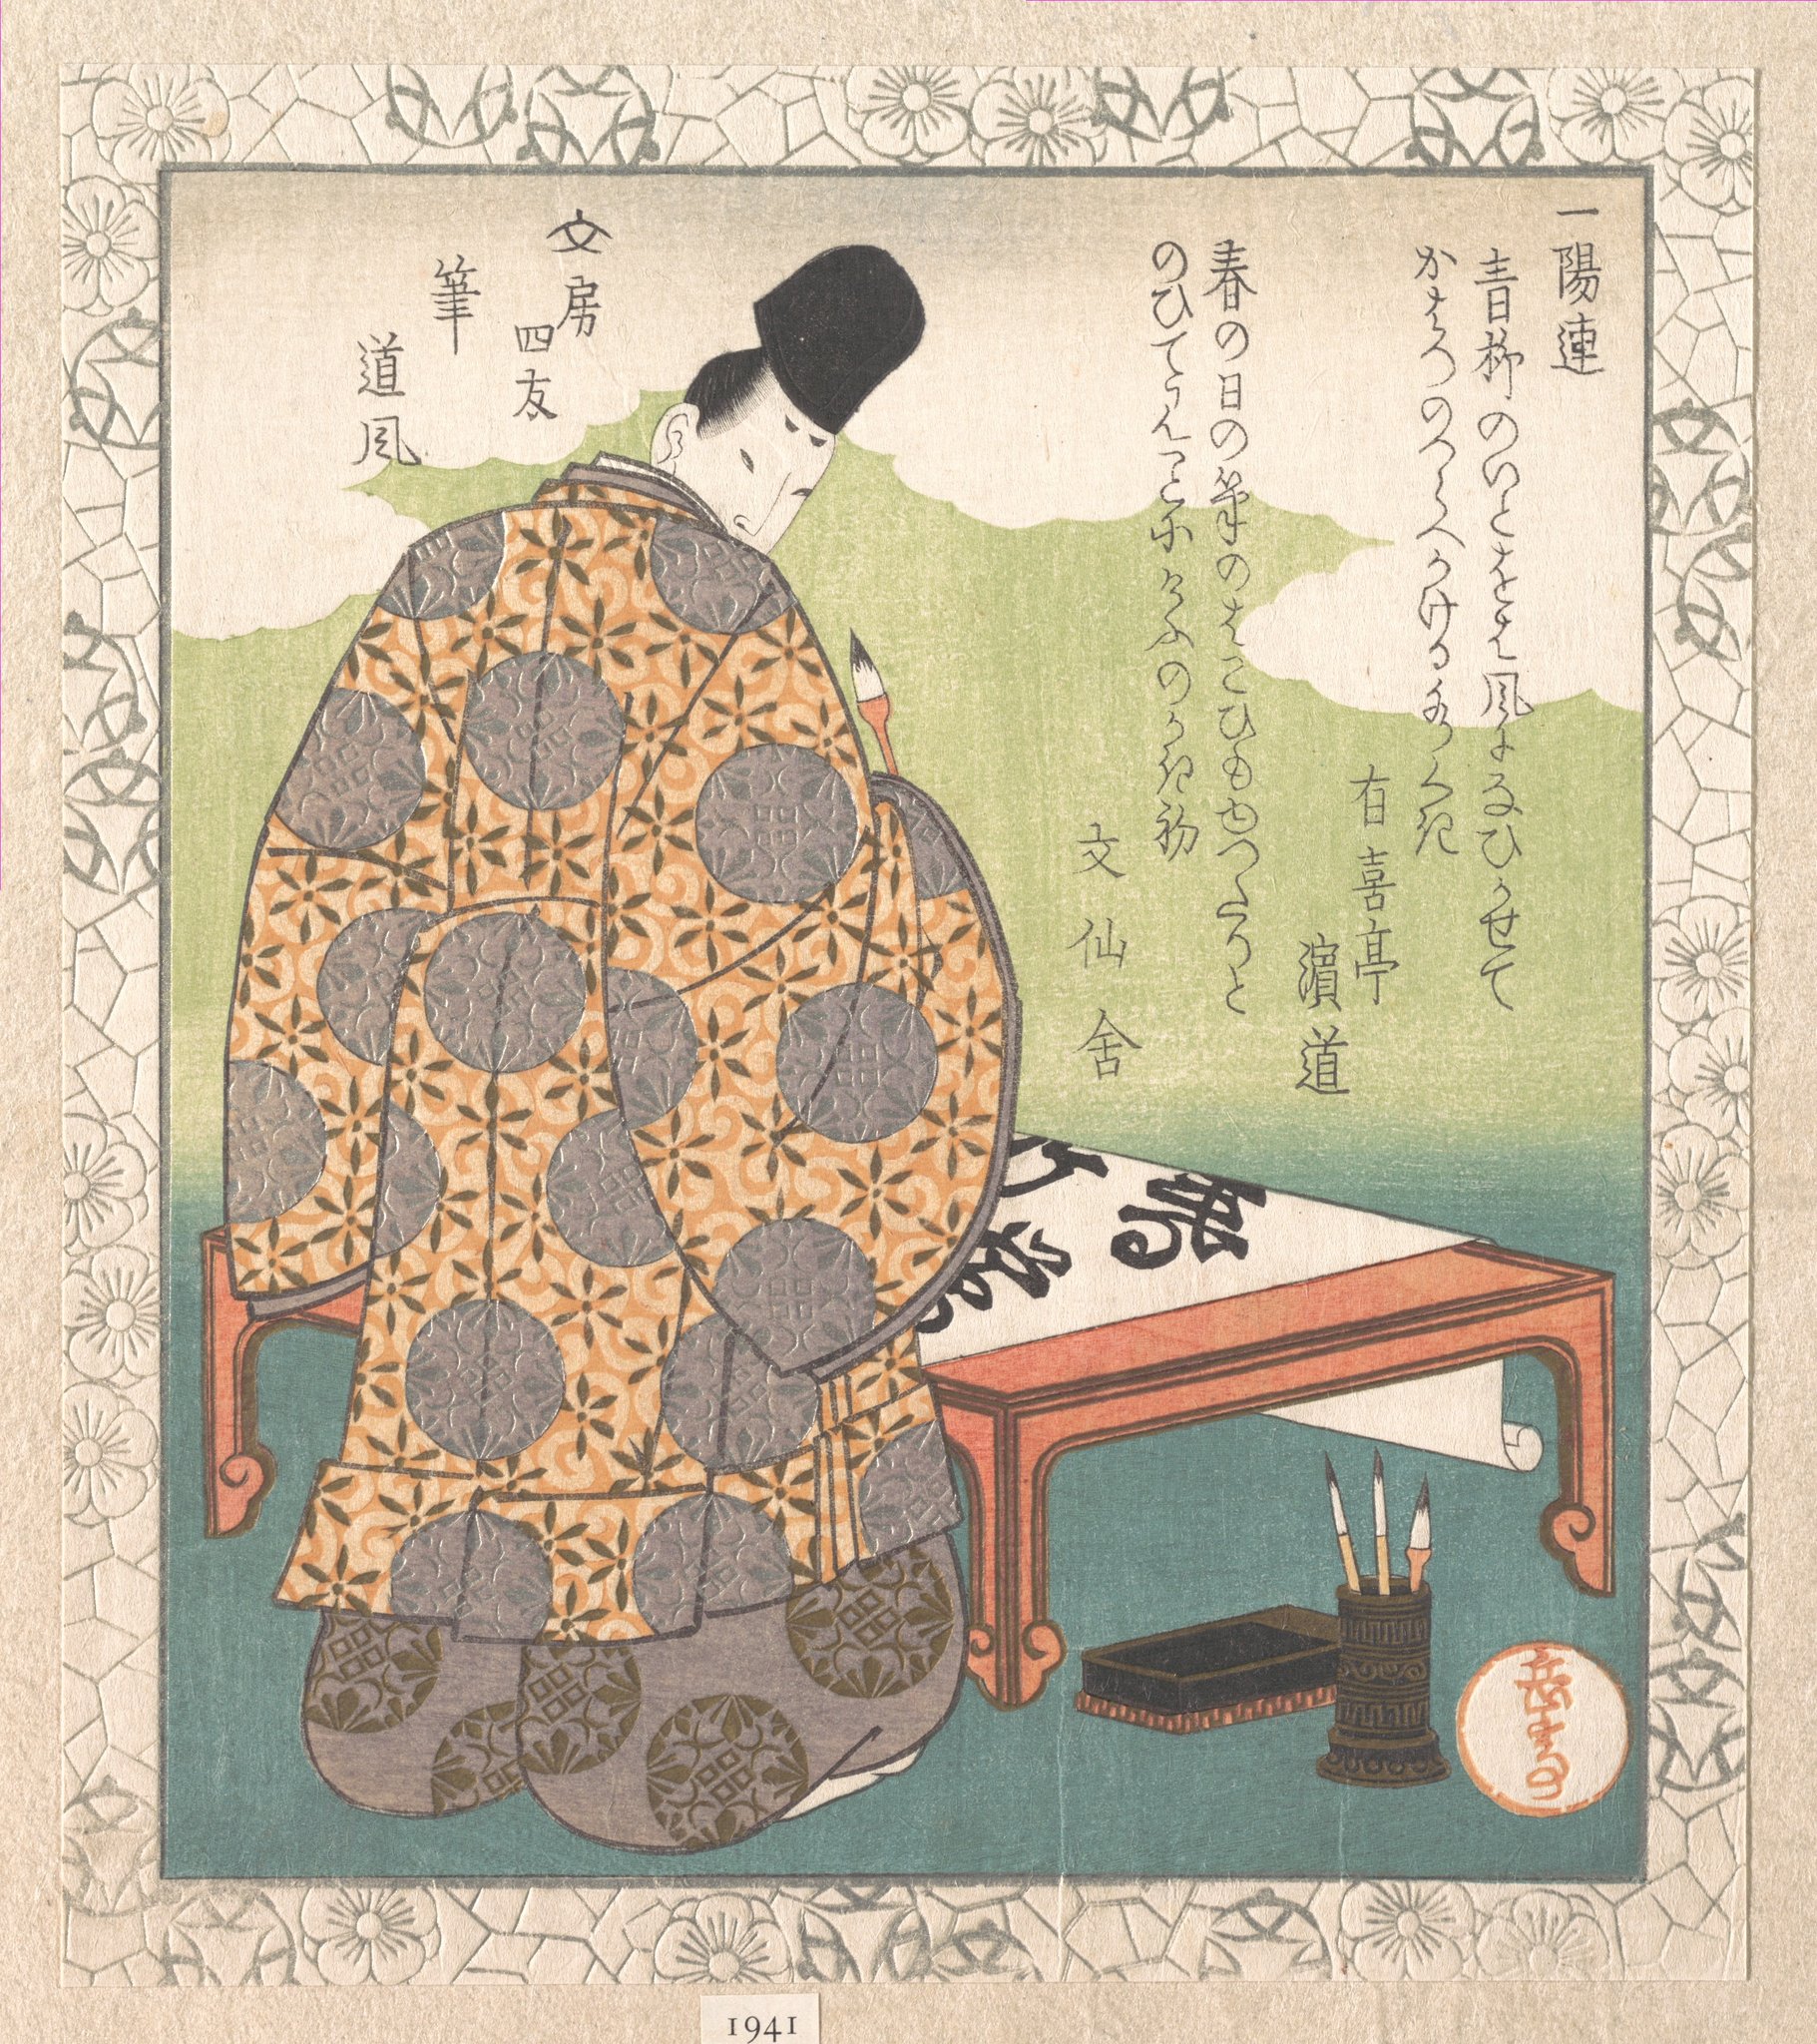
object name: print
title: The Heian Court Calligrapher Ono no Tōfū (894–966); “Calligraphy Brush” (Fude), from Four Friends of the Writing Table for the Ichiyō Poetry Circle (Ichiyō-ren Bunbō shiyū) From the Spring Rain Collection (Harusame shū), vol. 1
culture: japanese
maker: yashima gakutei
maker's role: artist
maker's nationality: japanese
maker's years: 1786-1868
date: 1827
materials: ink, paper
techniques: surimono, woodblock print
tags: men,writing,calligraphy,brushes